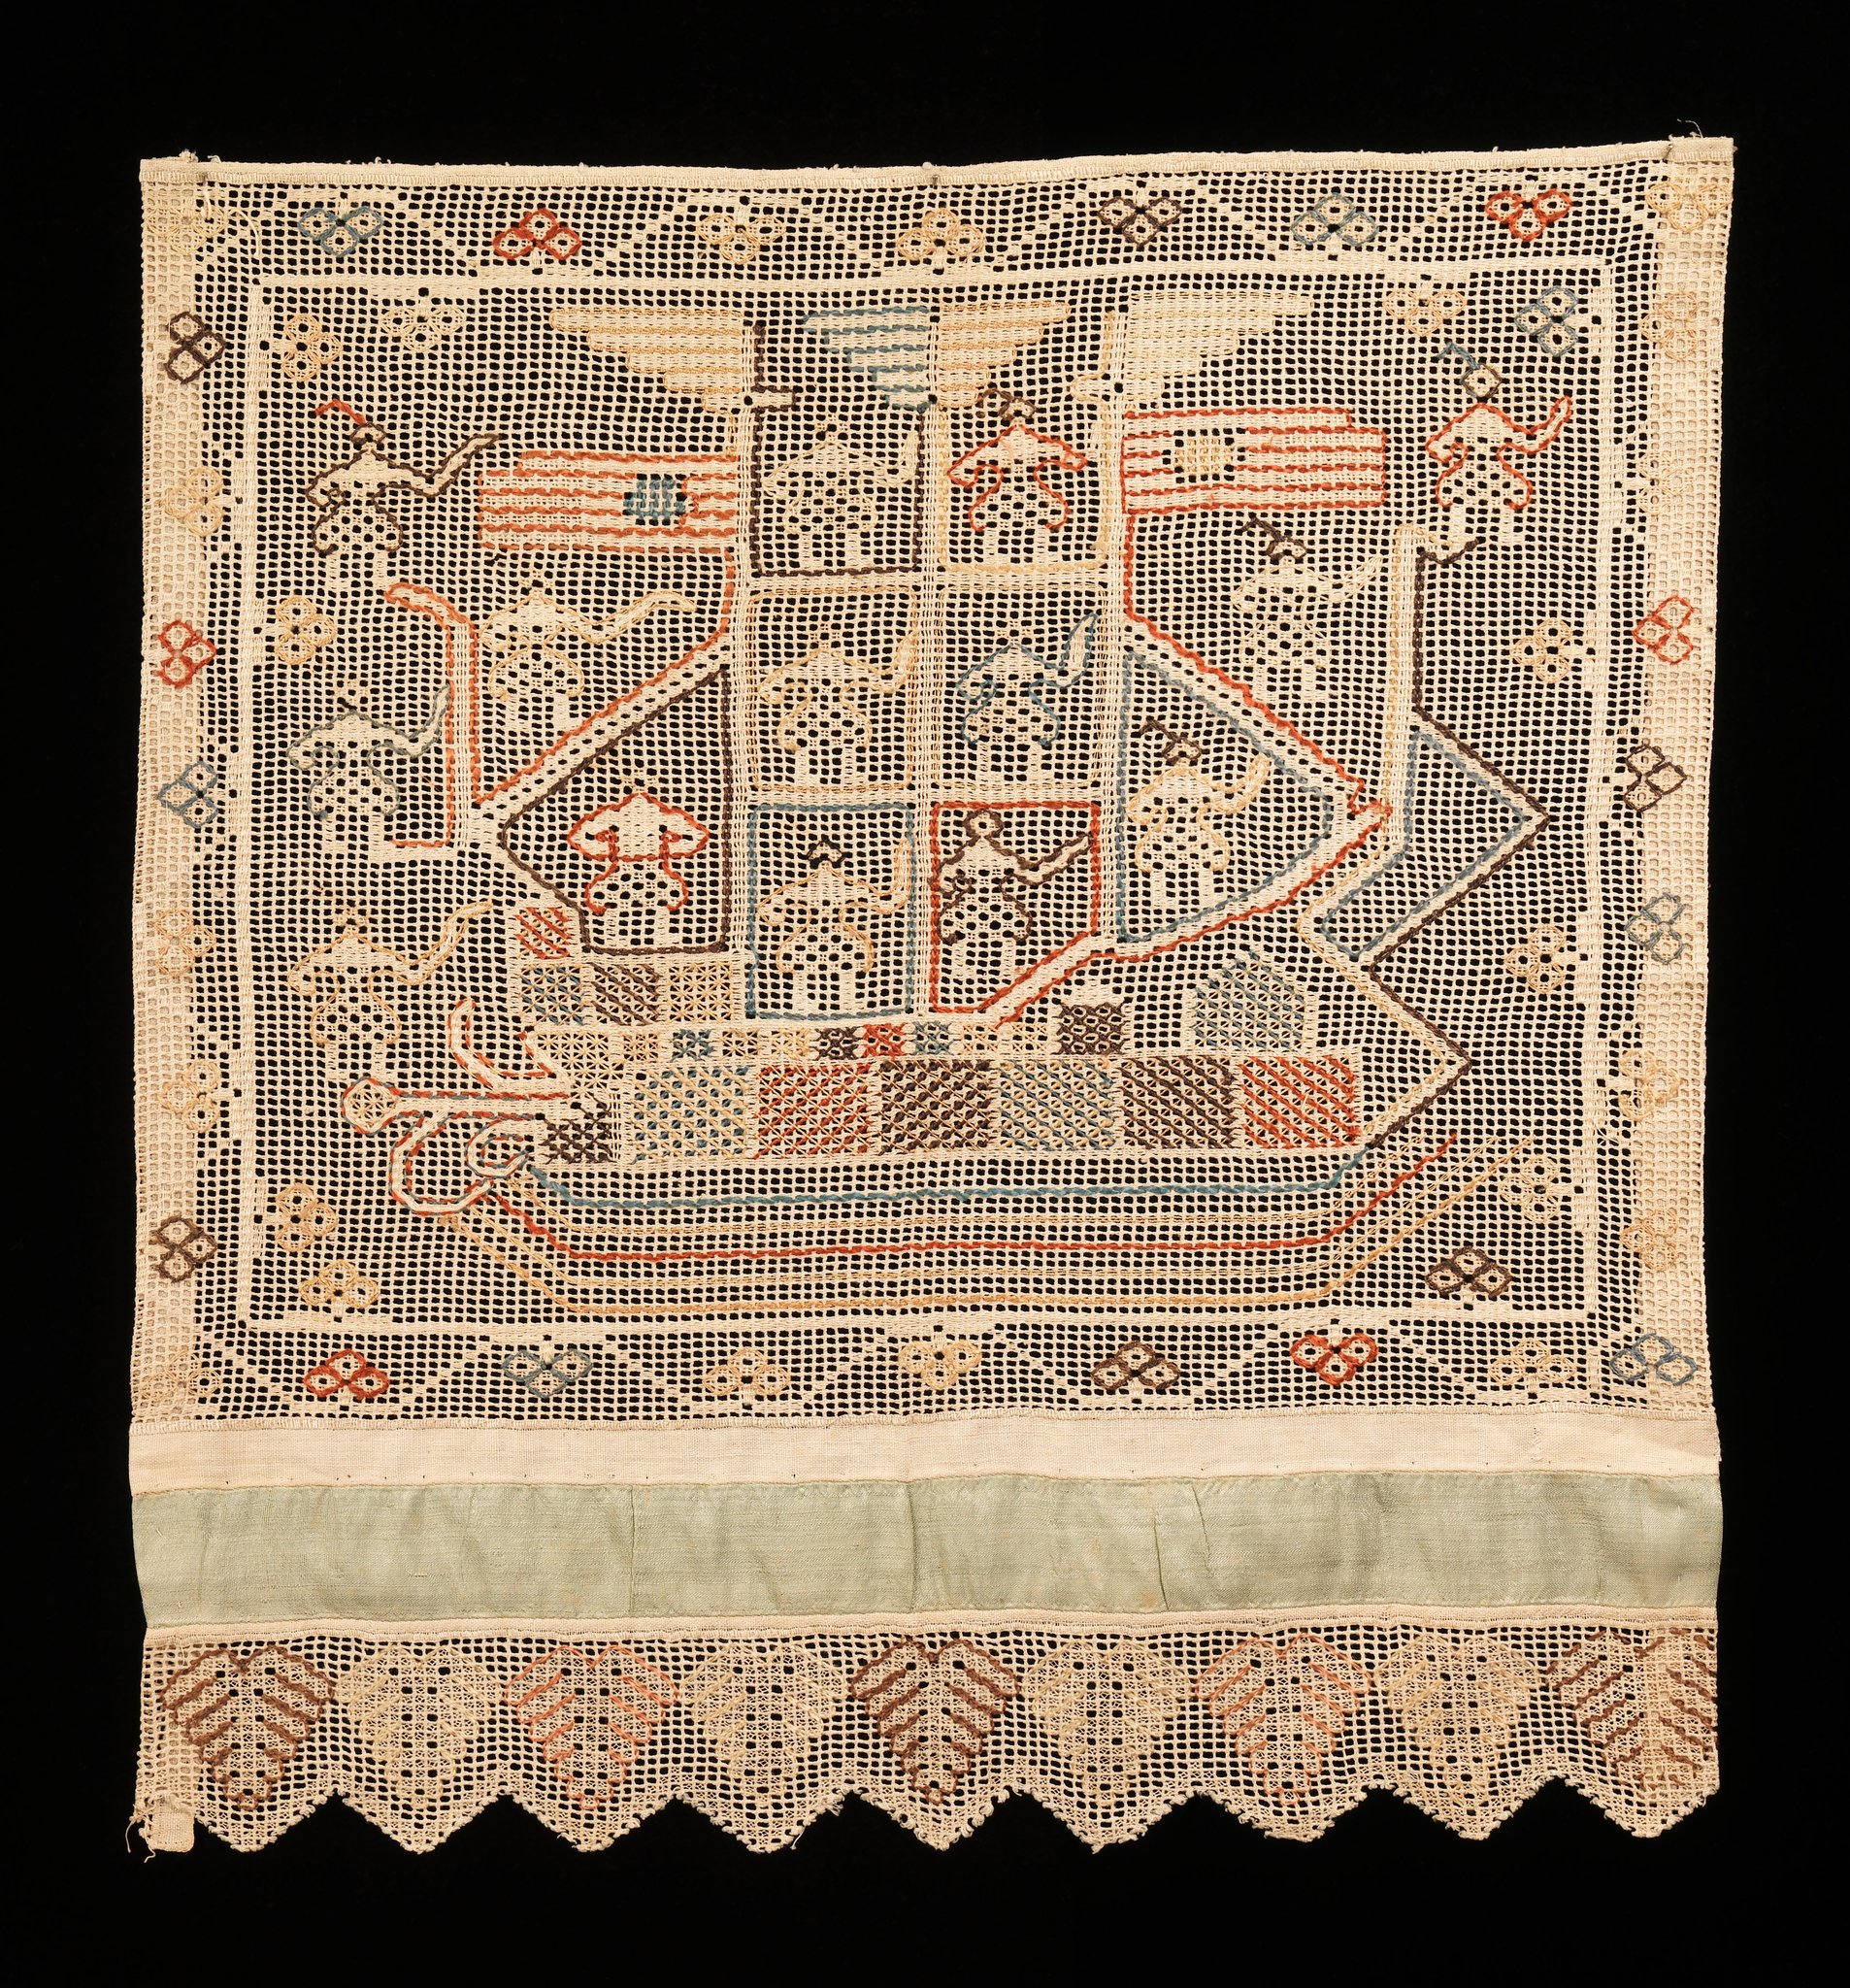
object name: border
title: Towel border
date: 1801-1833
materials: linen, silk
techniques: embroidery